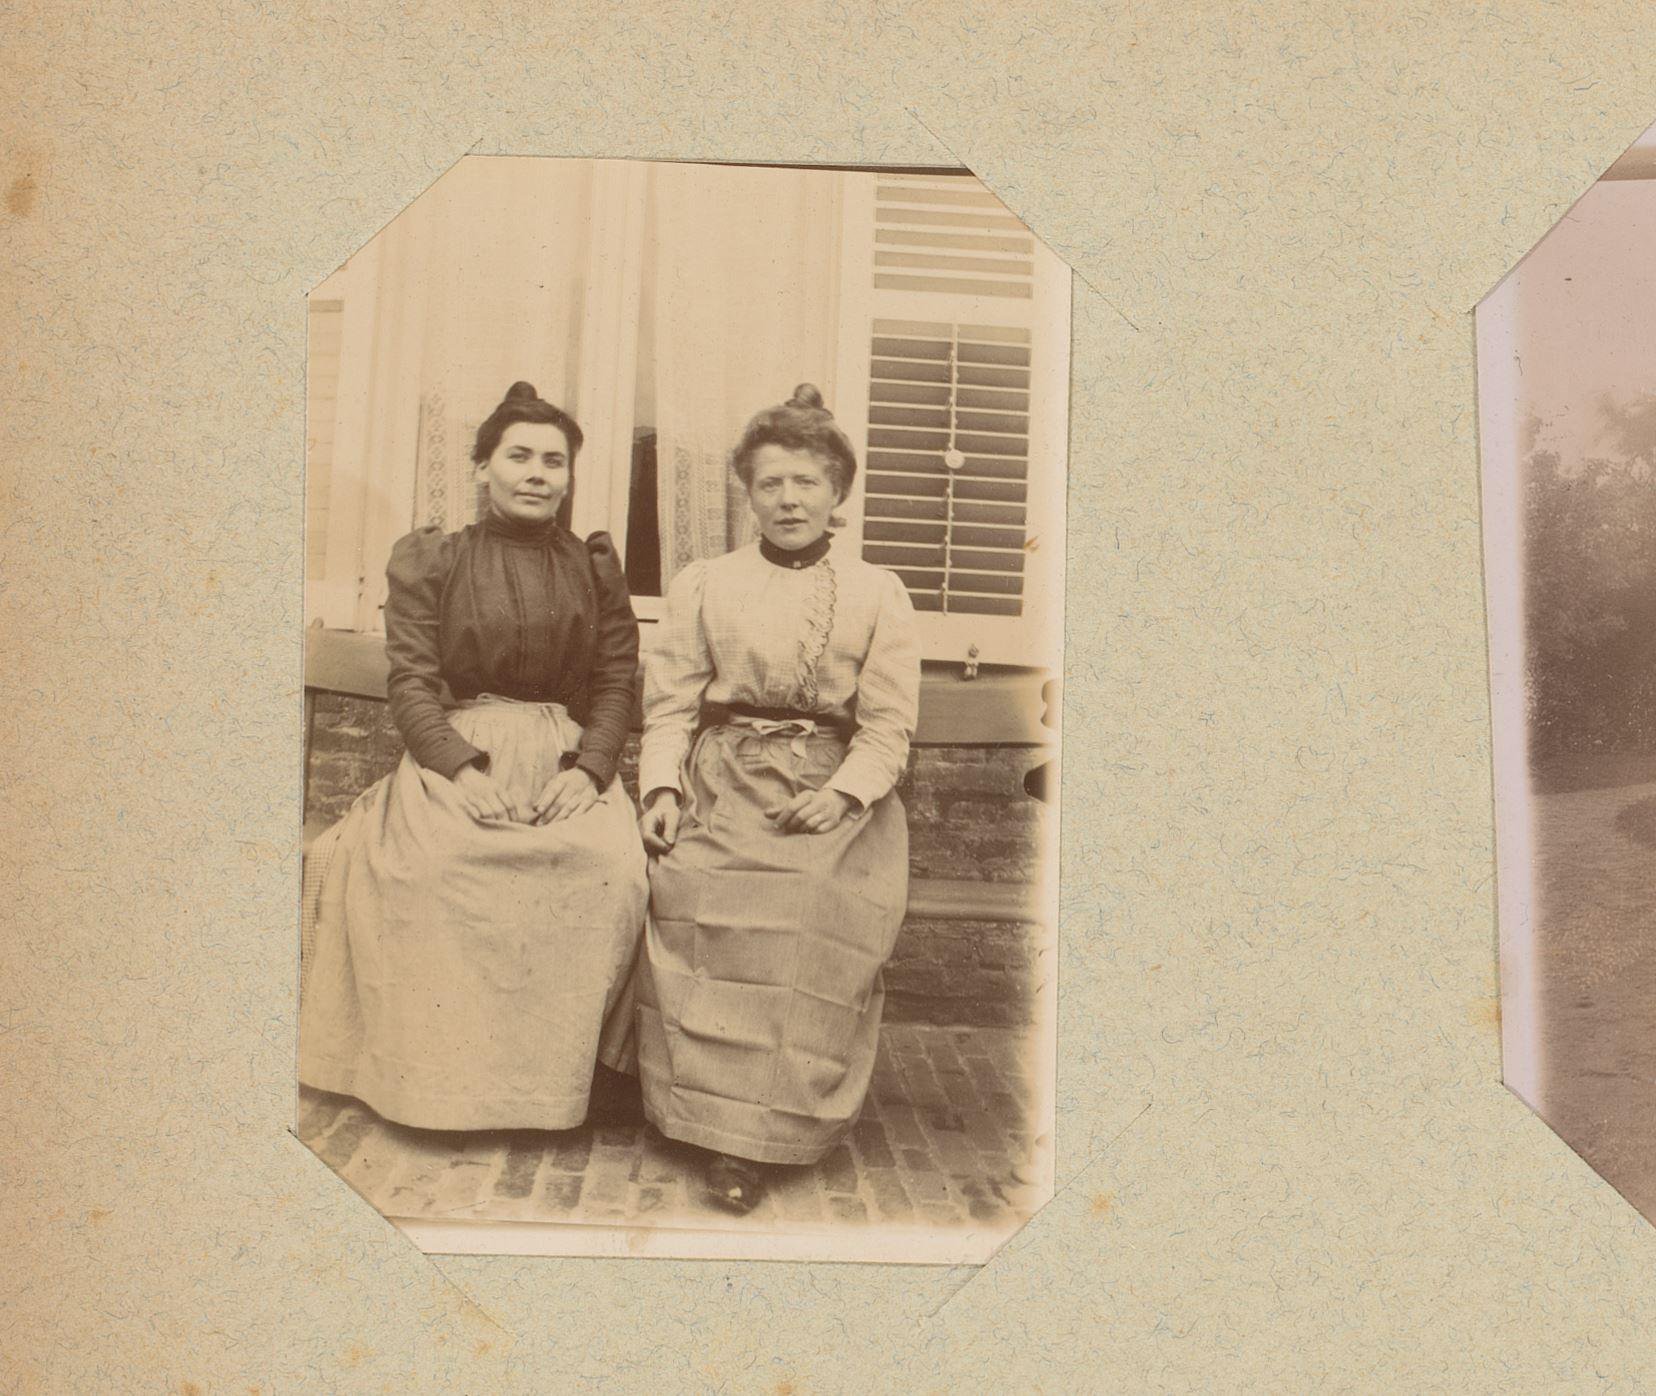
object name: album leaf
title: Portret van twee zittende jonge vrouwen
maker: Anonymous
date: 1897-1900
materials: paper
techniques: gelatin silver print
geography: france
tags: adolescent, young woman, maiden, historical persons, france